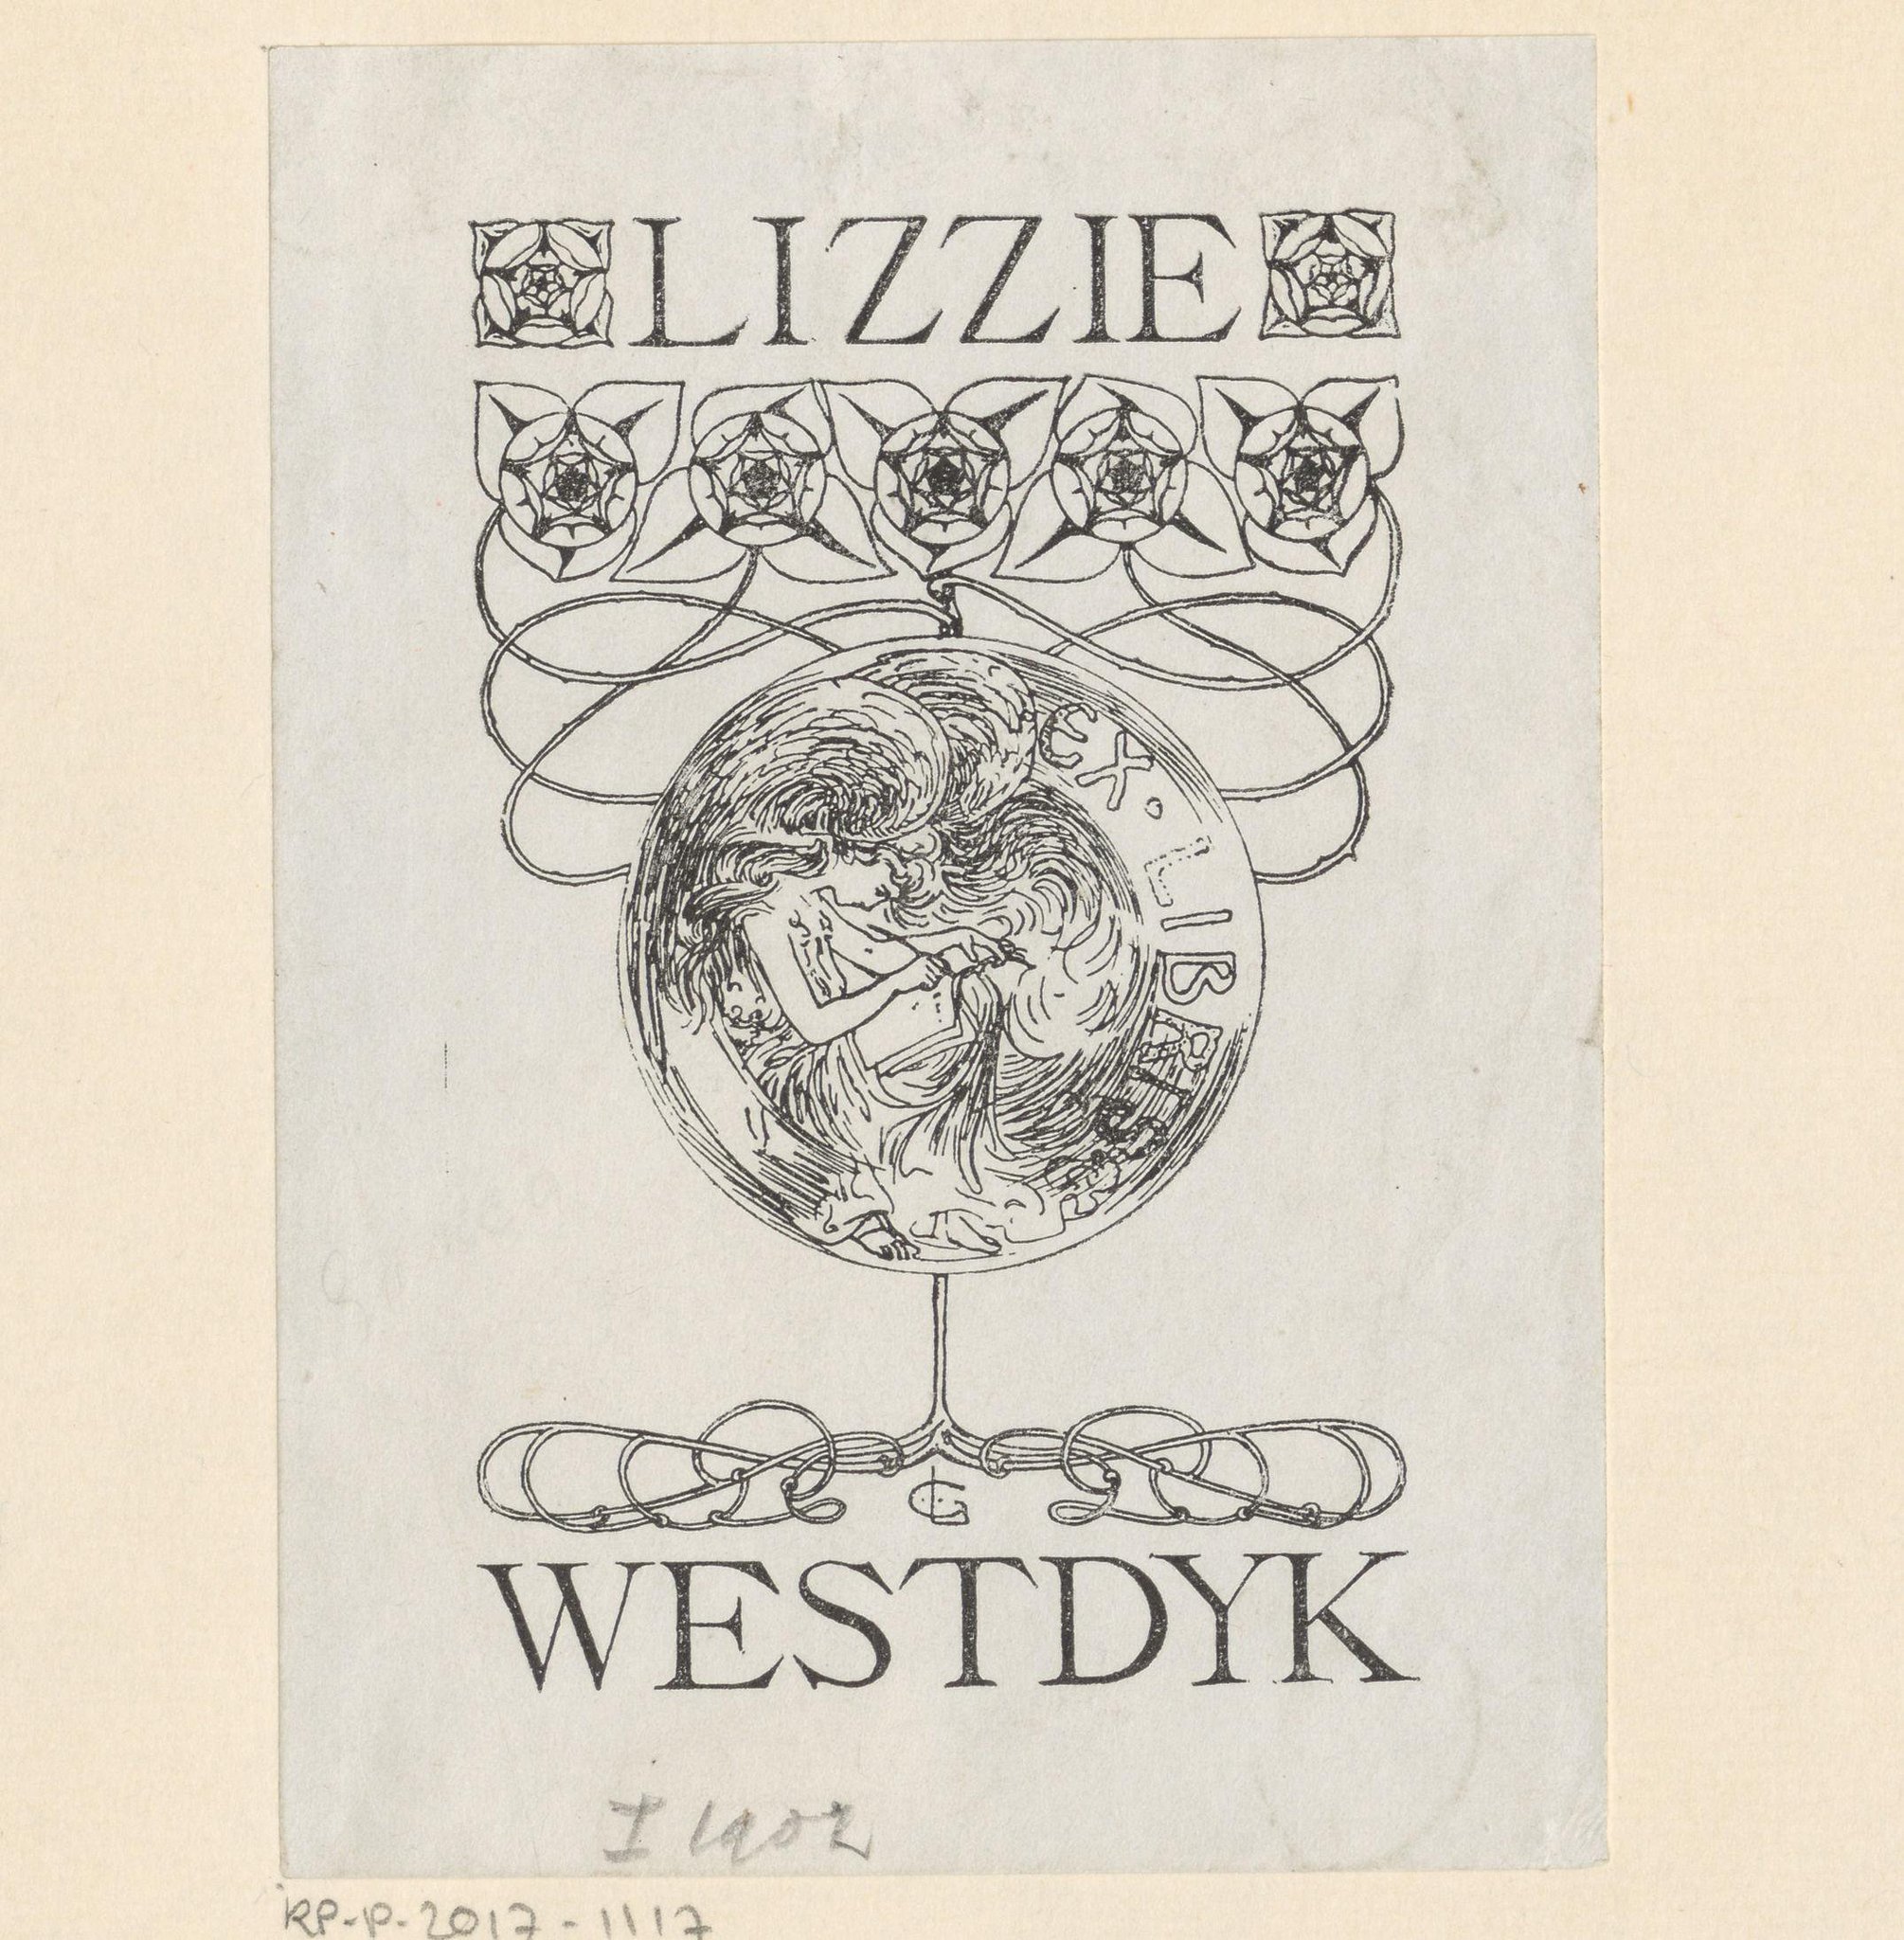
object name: bookplate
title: Ex libris van Lizzie Westdijk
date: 1891-1941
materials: paper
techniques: printing block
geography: netherlands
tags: adolescent, young woman, maiden, reading, tousled hair, shrubs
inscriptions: inscription: ‘±1902’